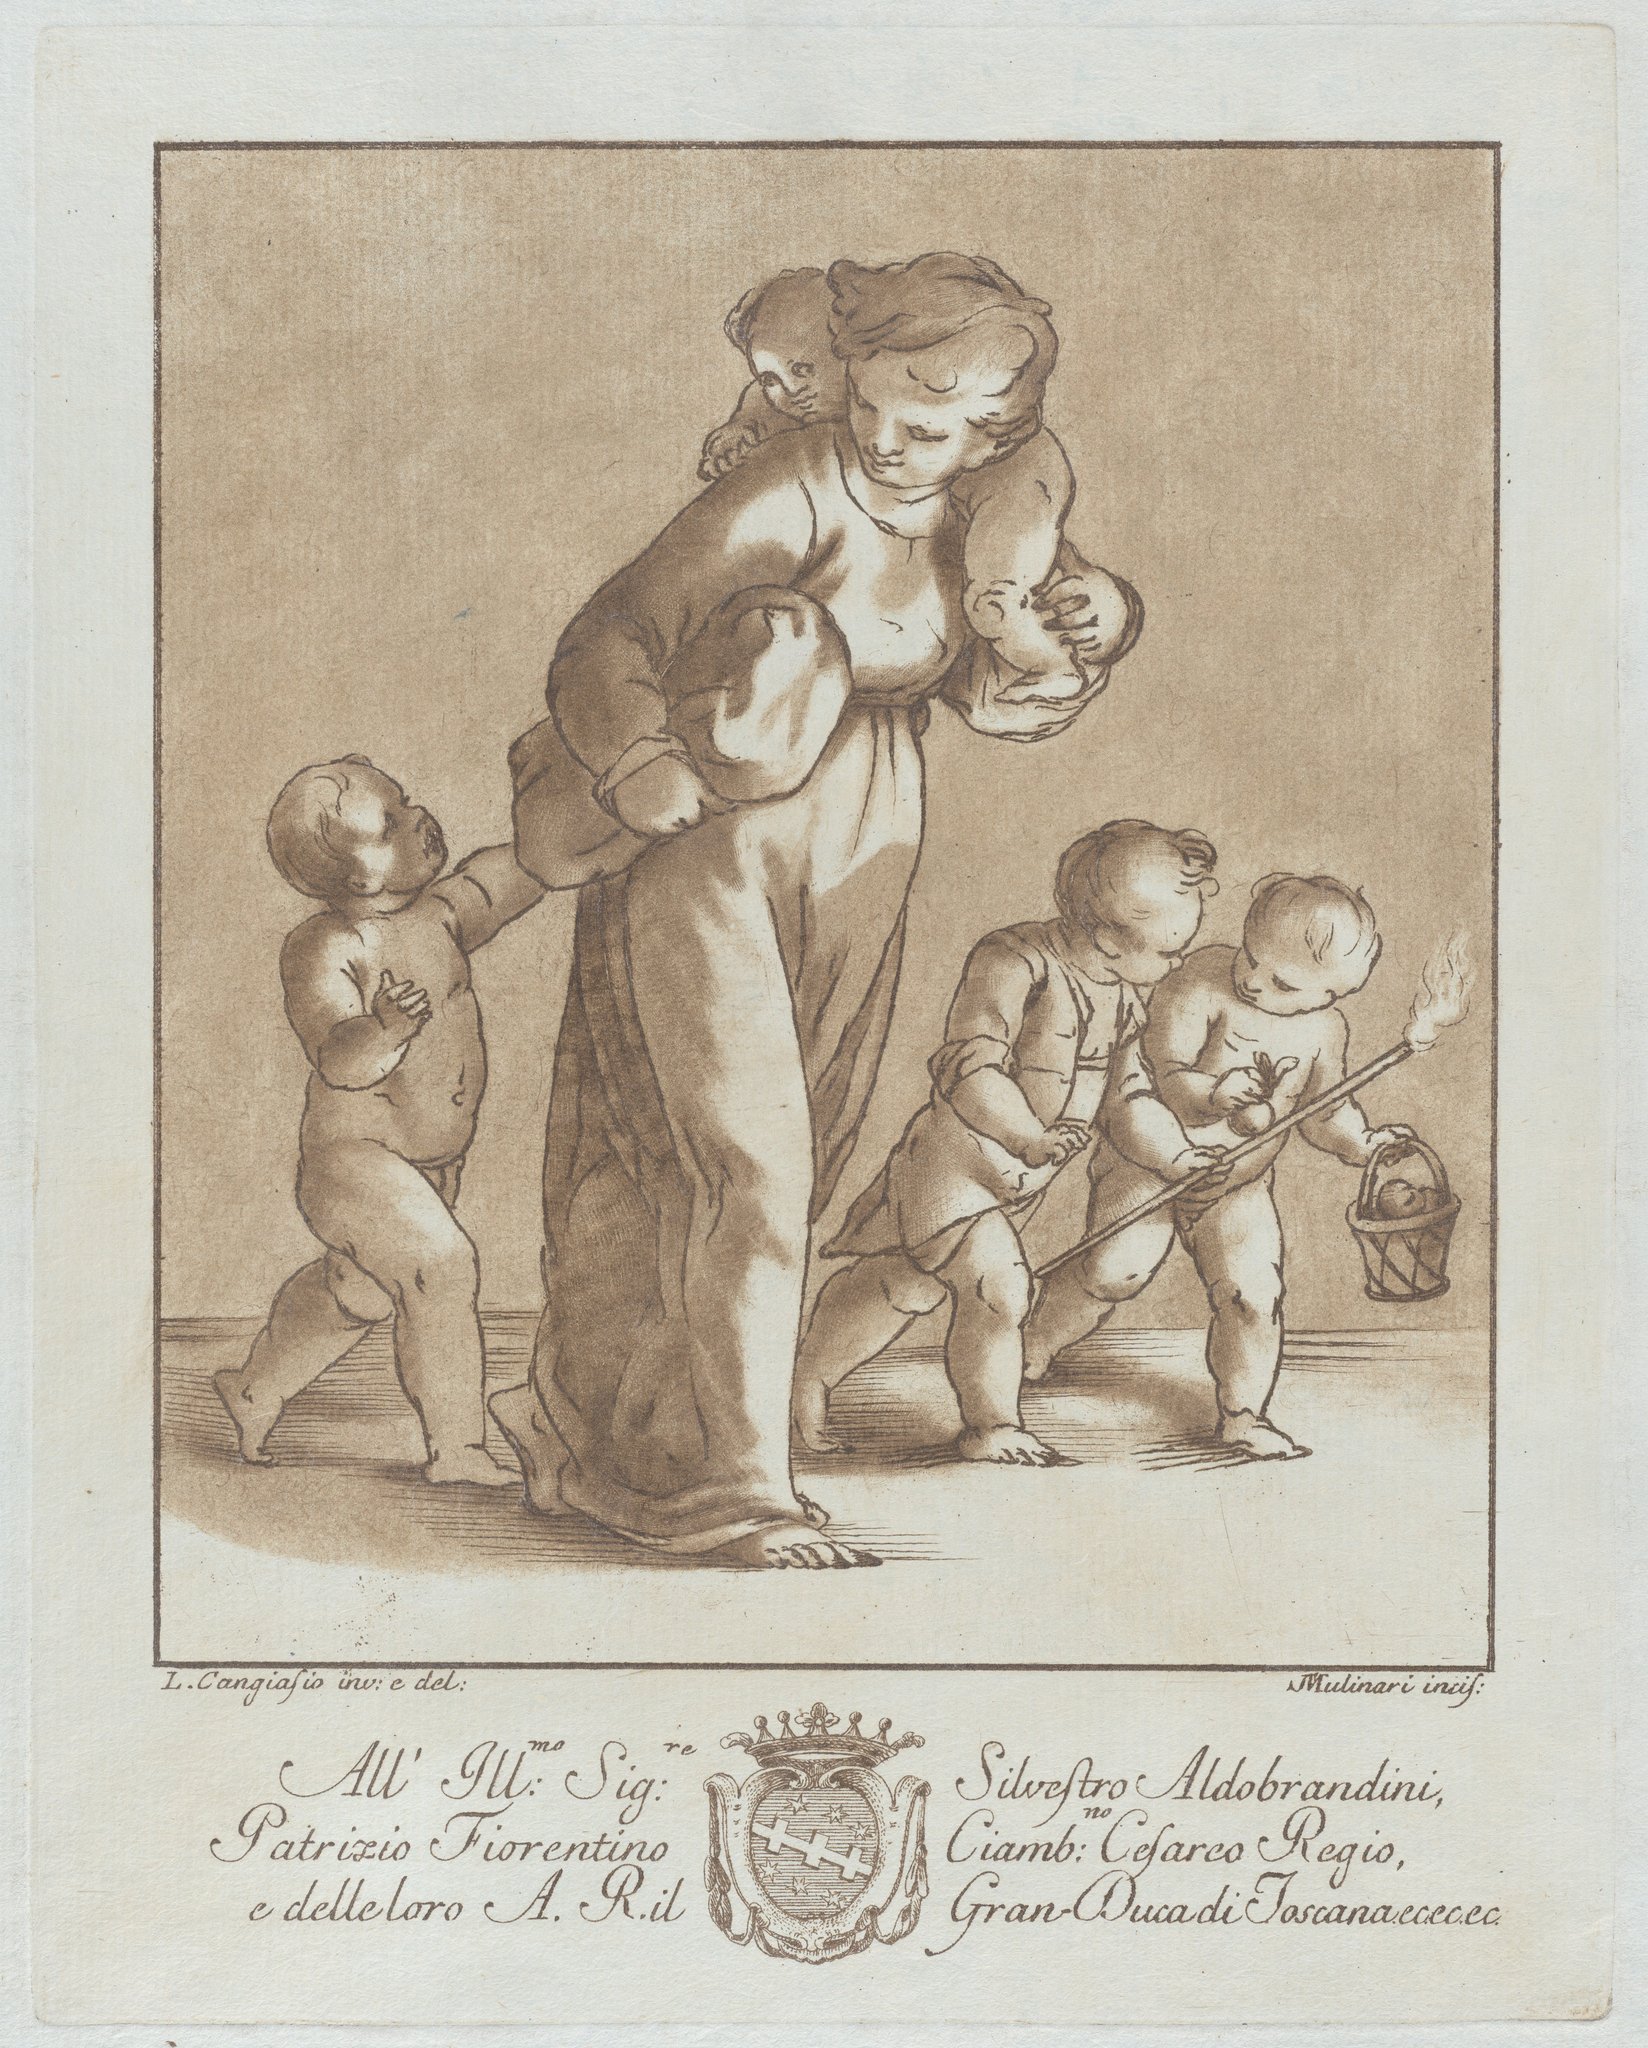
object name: print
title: A young girl walks towards the left with one infant on her shoulder and holding another small child's hand, while two children walk at right with a torch and a basket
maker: stefano mulinari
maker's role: artist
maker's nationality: italian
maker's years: 1736-1795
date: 1780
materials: paper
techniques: etching, wash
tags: children,girls